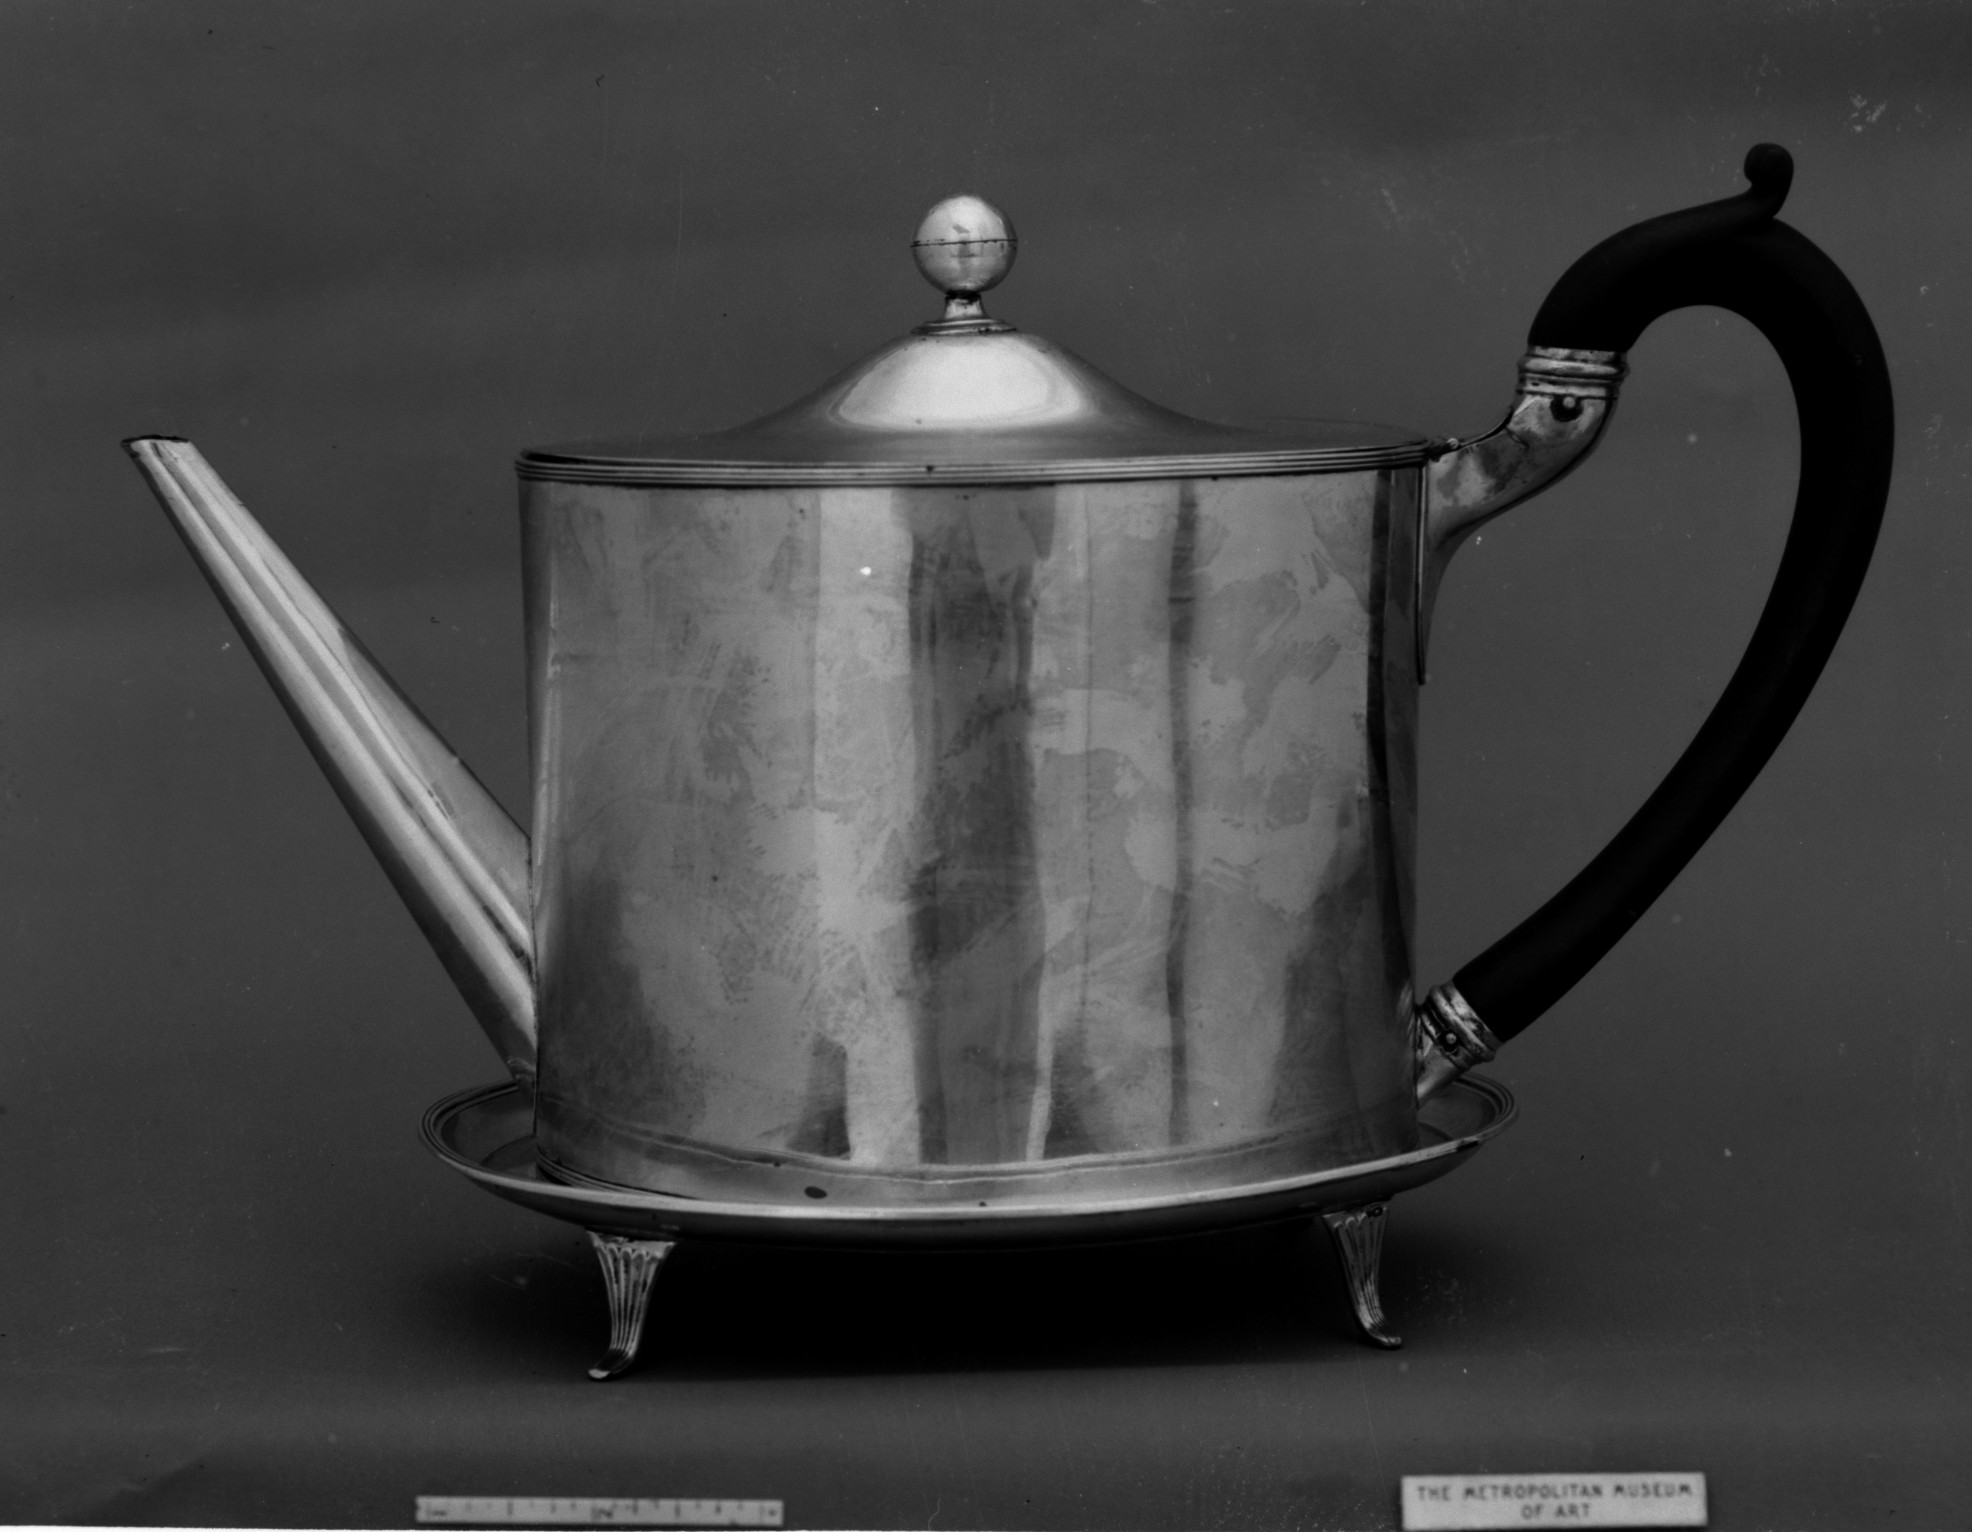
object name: argyle and stand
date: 1790-1795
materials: metal, wood